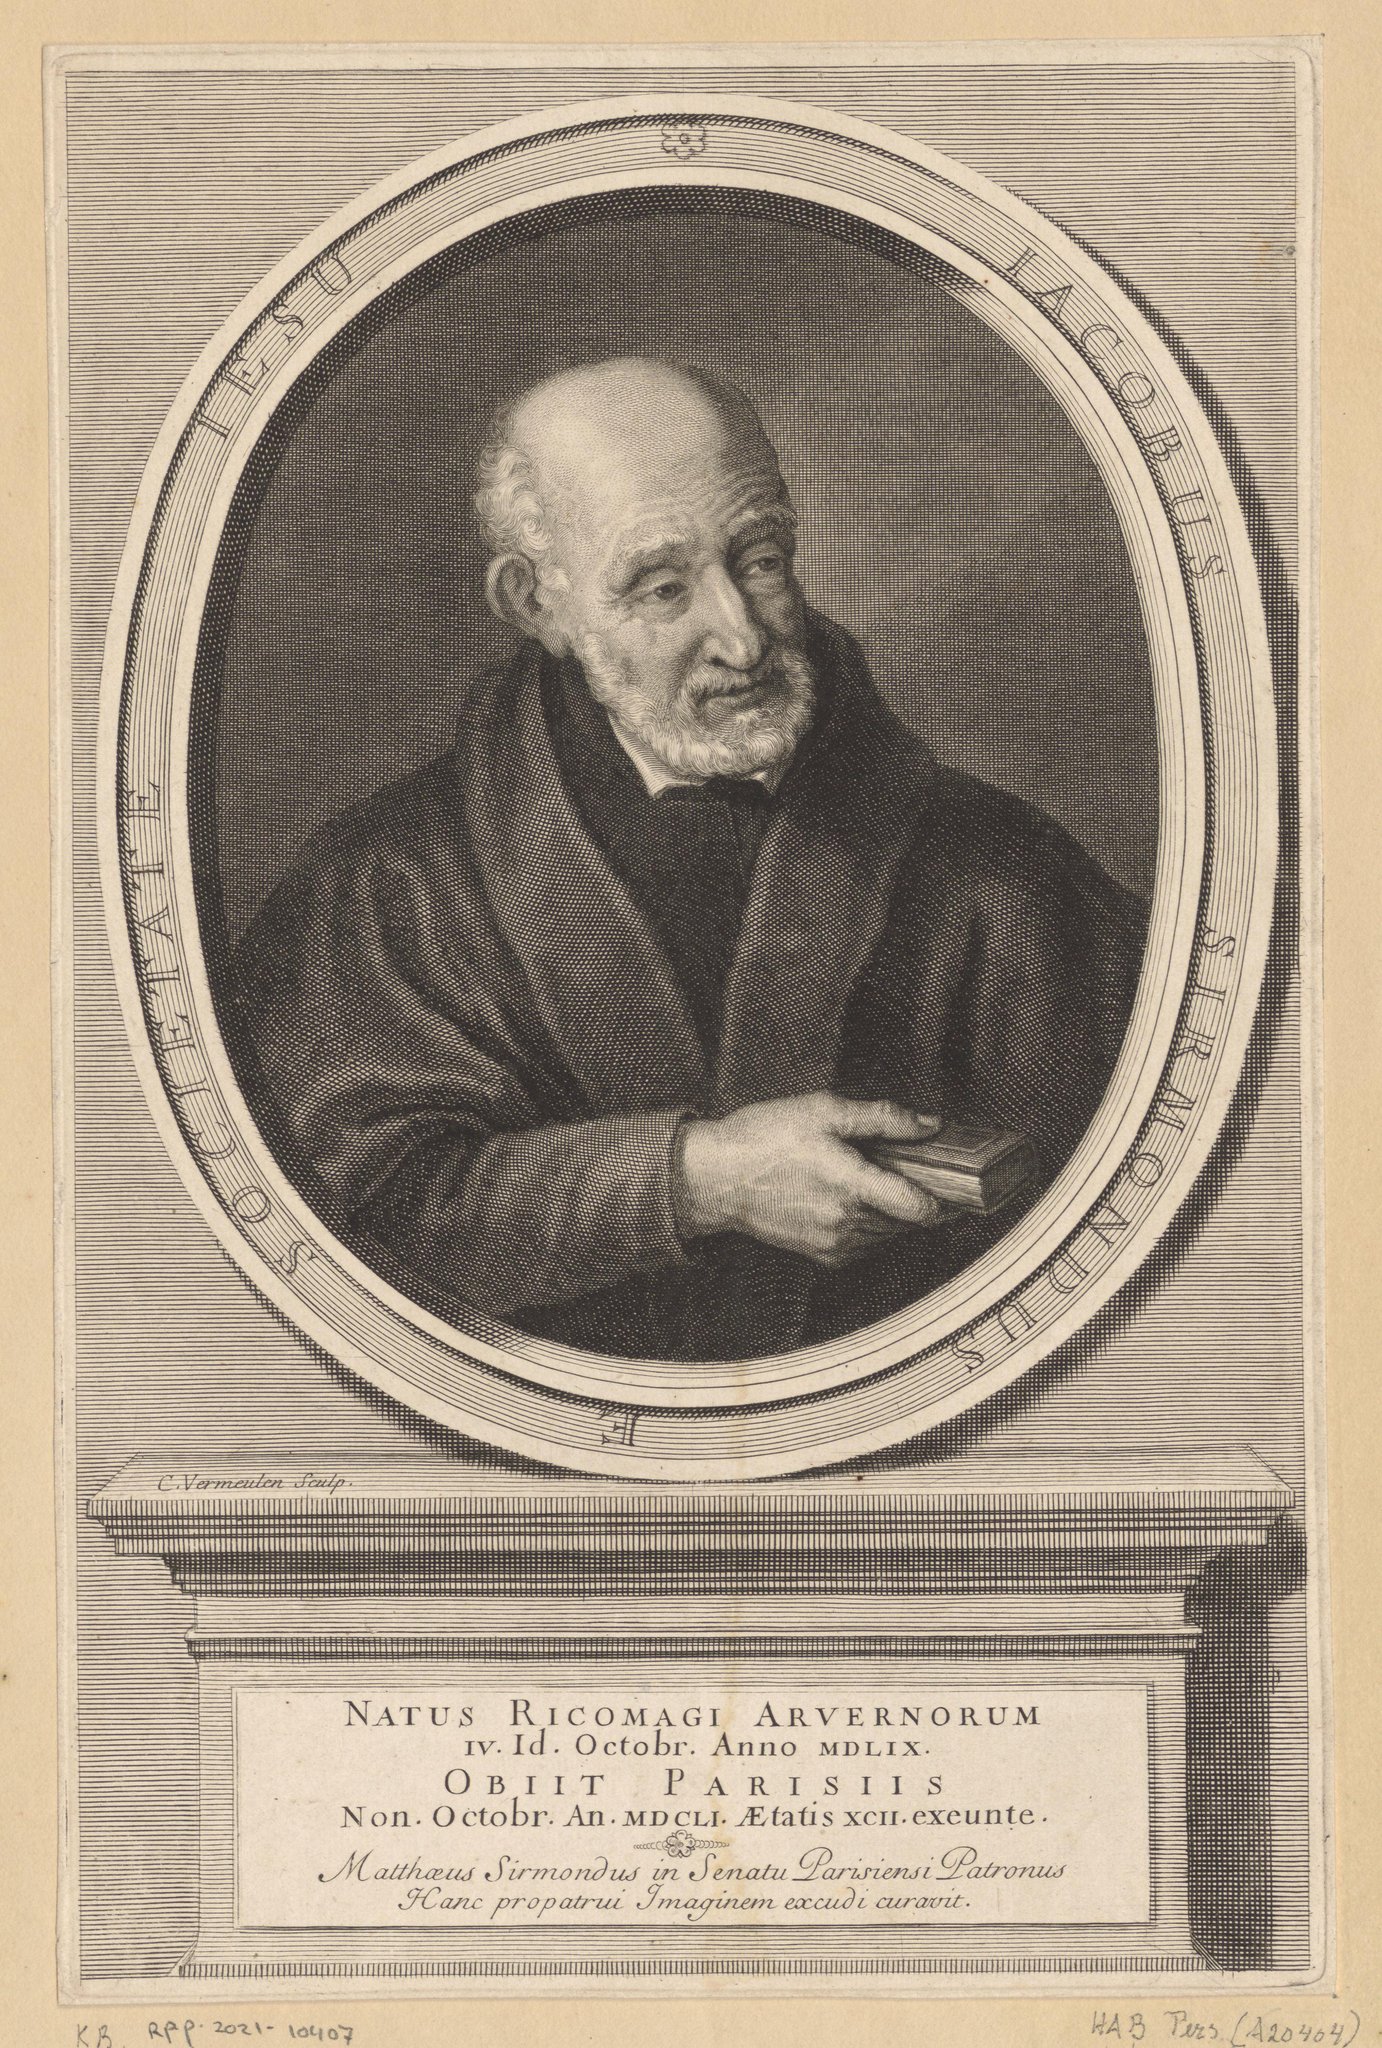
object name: print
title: Portret van Jacques Sirmond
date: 1654-1708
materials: paper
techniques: engraving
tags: priest, historical persons, book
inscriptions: collector's mark: Lugt 240